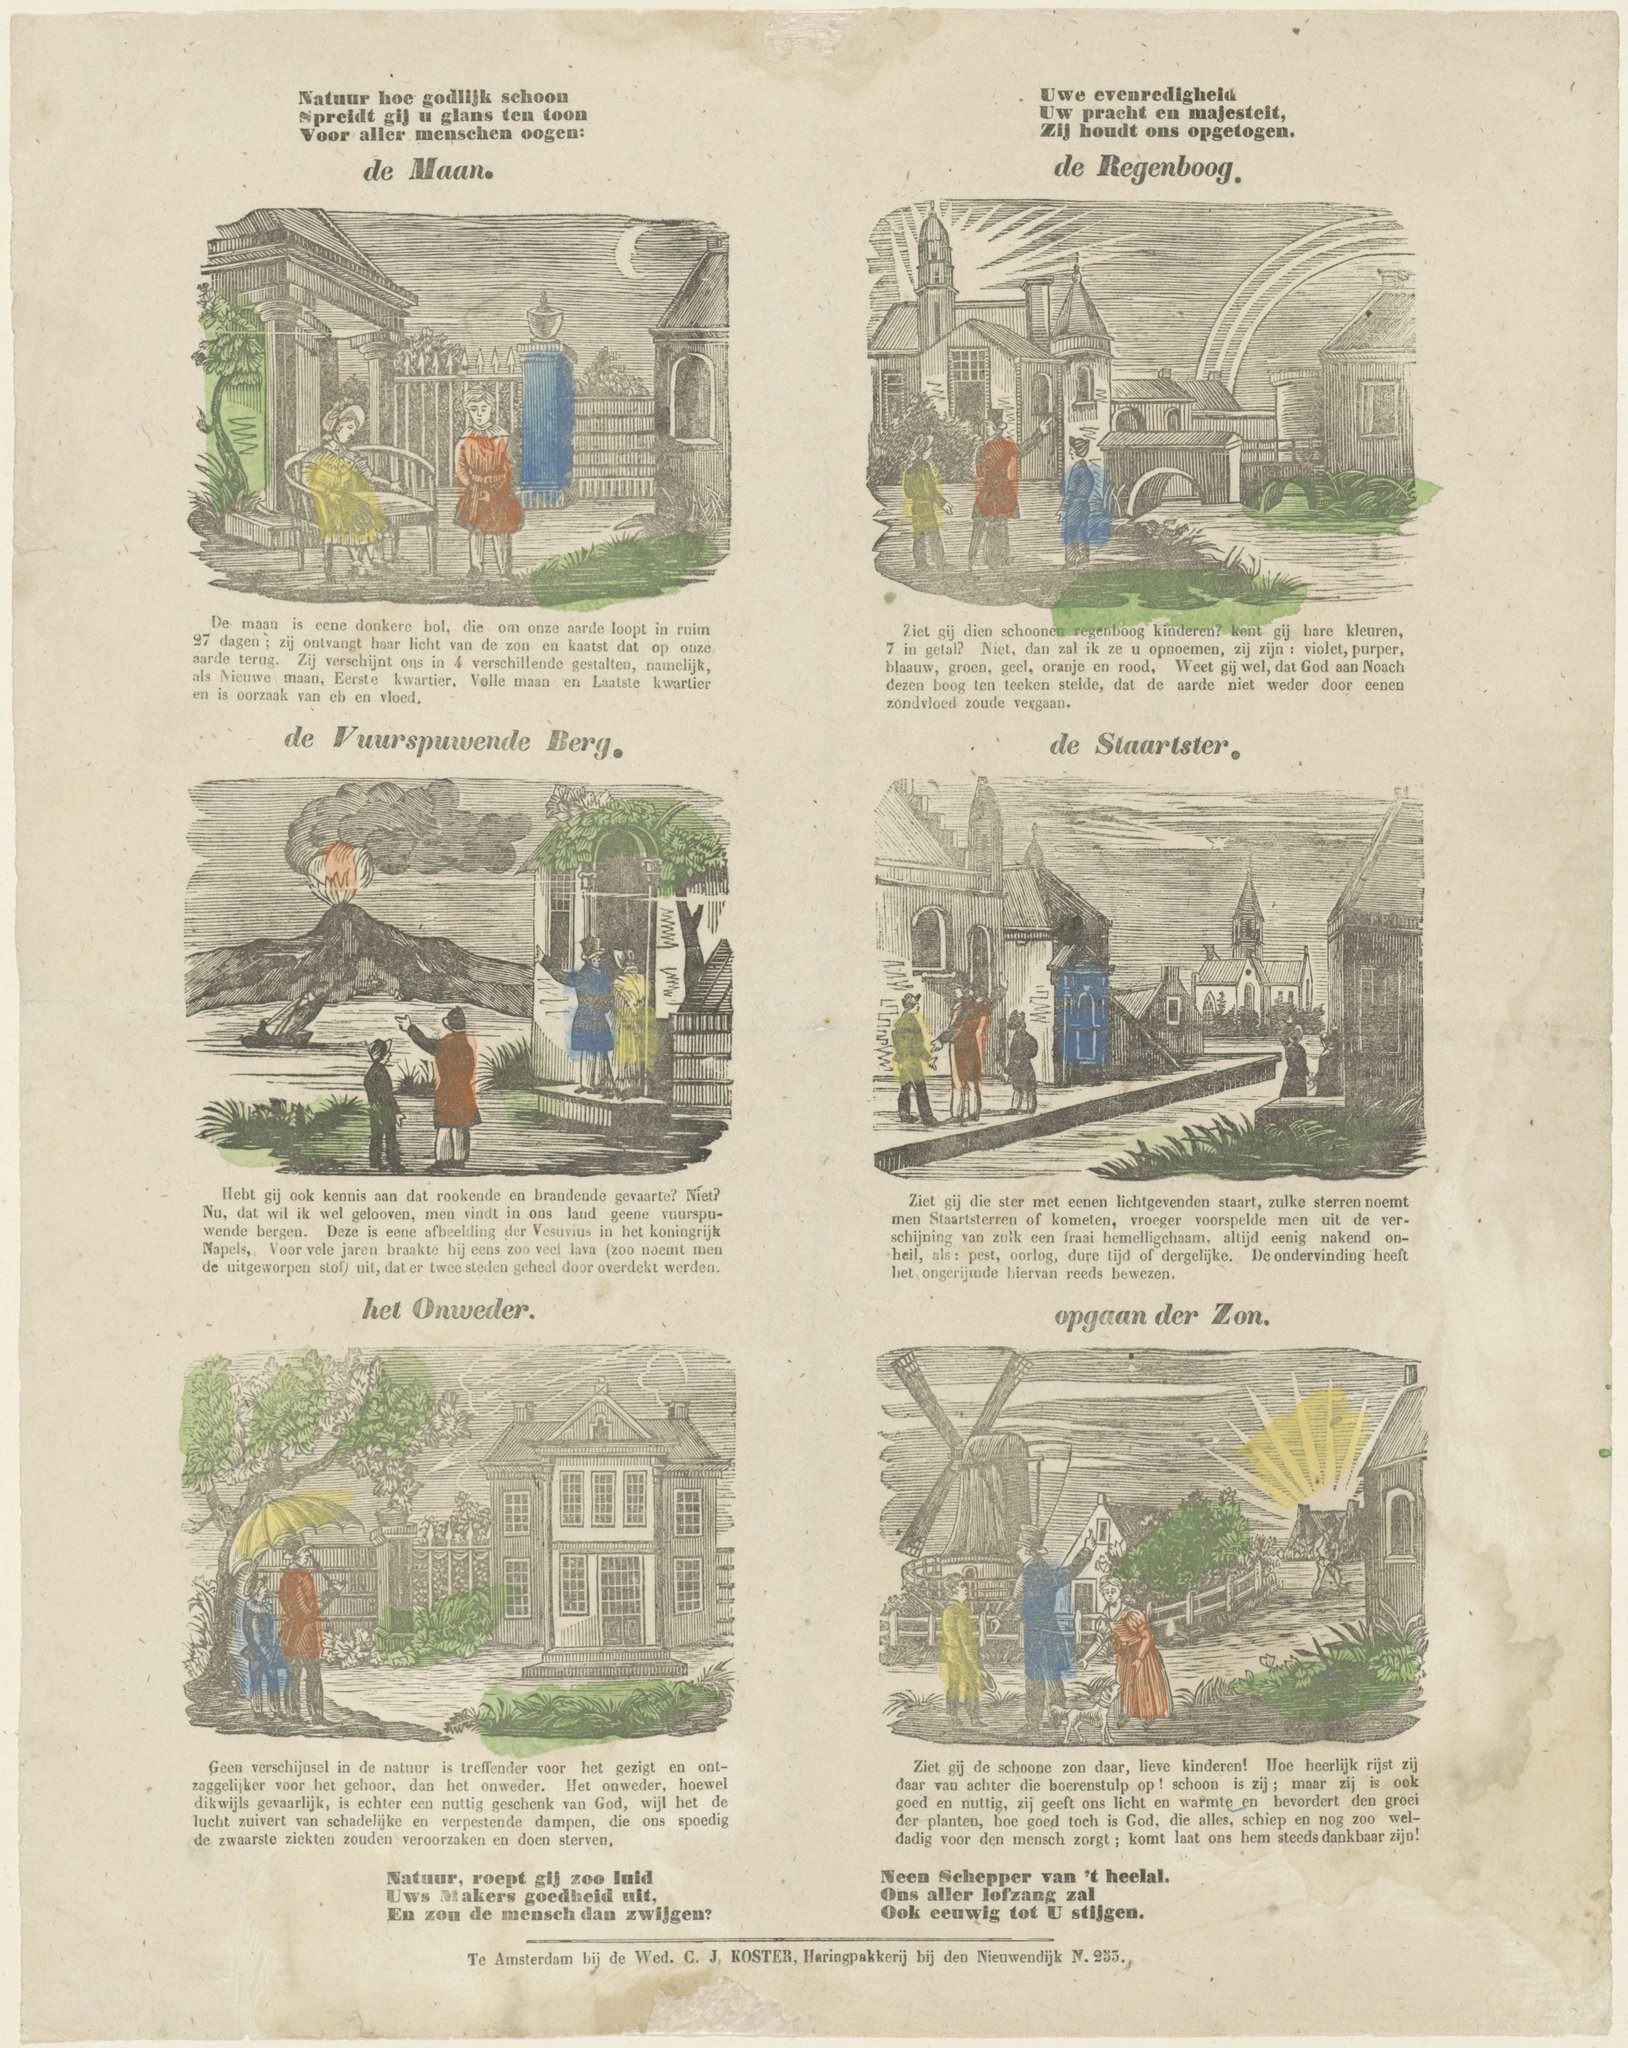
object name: popular print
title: Natuur hoe goddelijk schoon / Spreidt gij u glans ten toon (...)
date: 1825-1847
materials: paper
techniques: colour, letterpress printing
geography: netherlands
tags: meteorological phenomena, natural phenomena, day and night, volcano, rainbow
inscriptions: collector's mark: Lugt 2760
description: Blad met 6 voorstellingen van natuurverschijnselen, waaronder de maan, een vulkaan en onweer. Onder elke afbeelding een onderschrift en boven elke afbeelding een titel.